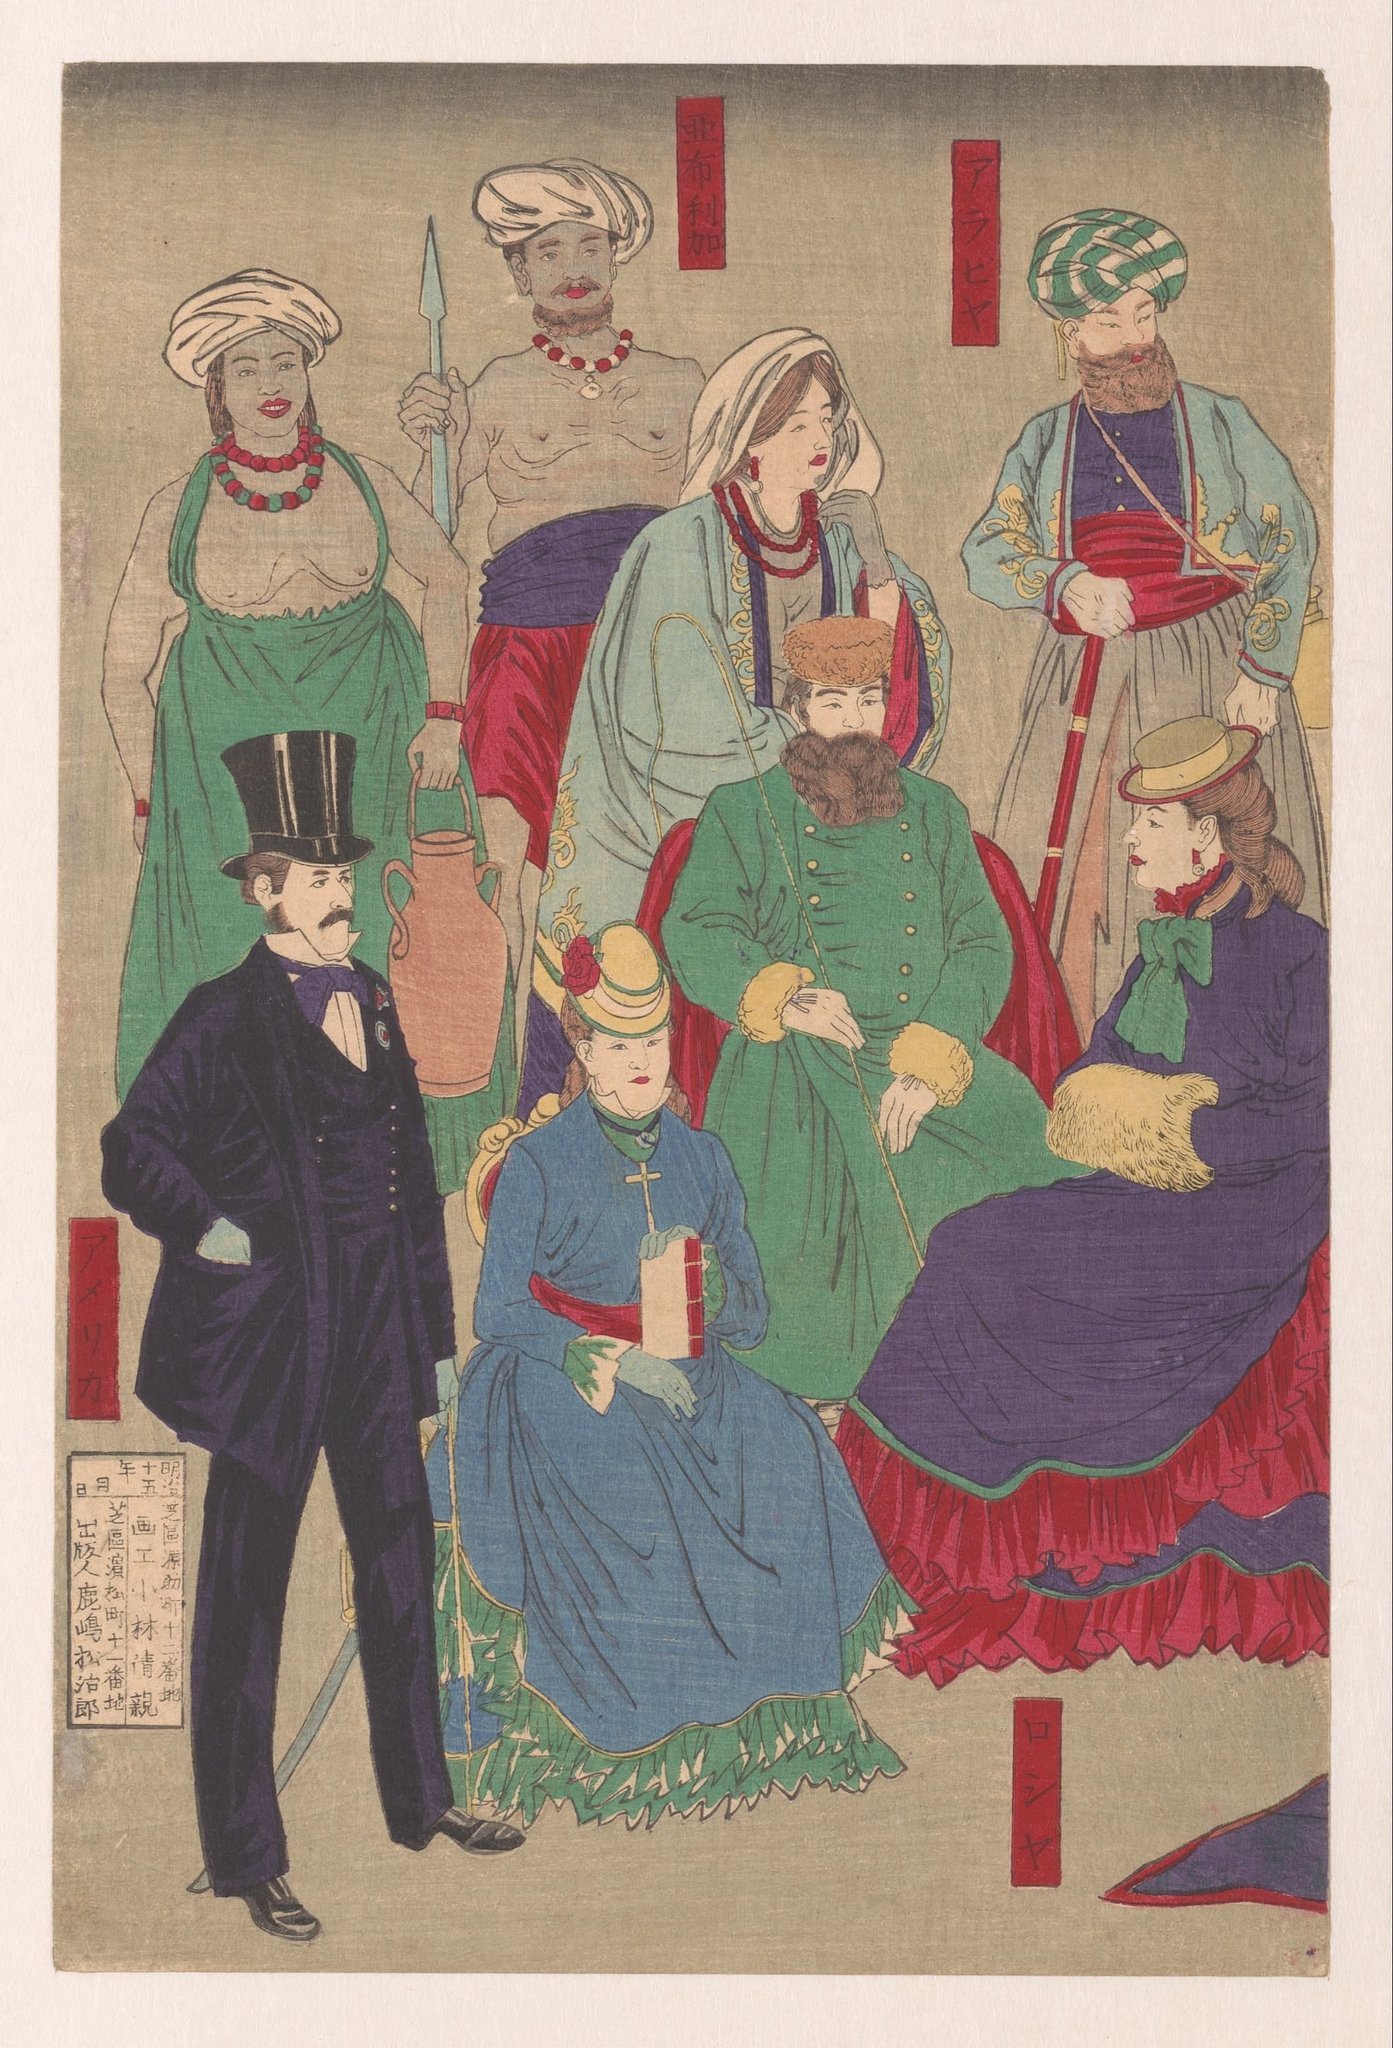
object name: print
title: Weergave van klederdracht in alle landen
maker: kobayashi kiyochika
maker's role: print maker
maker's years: 1847-1915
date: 1882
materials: paper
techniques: woodcut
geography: japan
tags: human types; peoples and nationalities, folk costume, regional costume